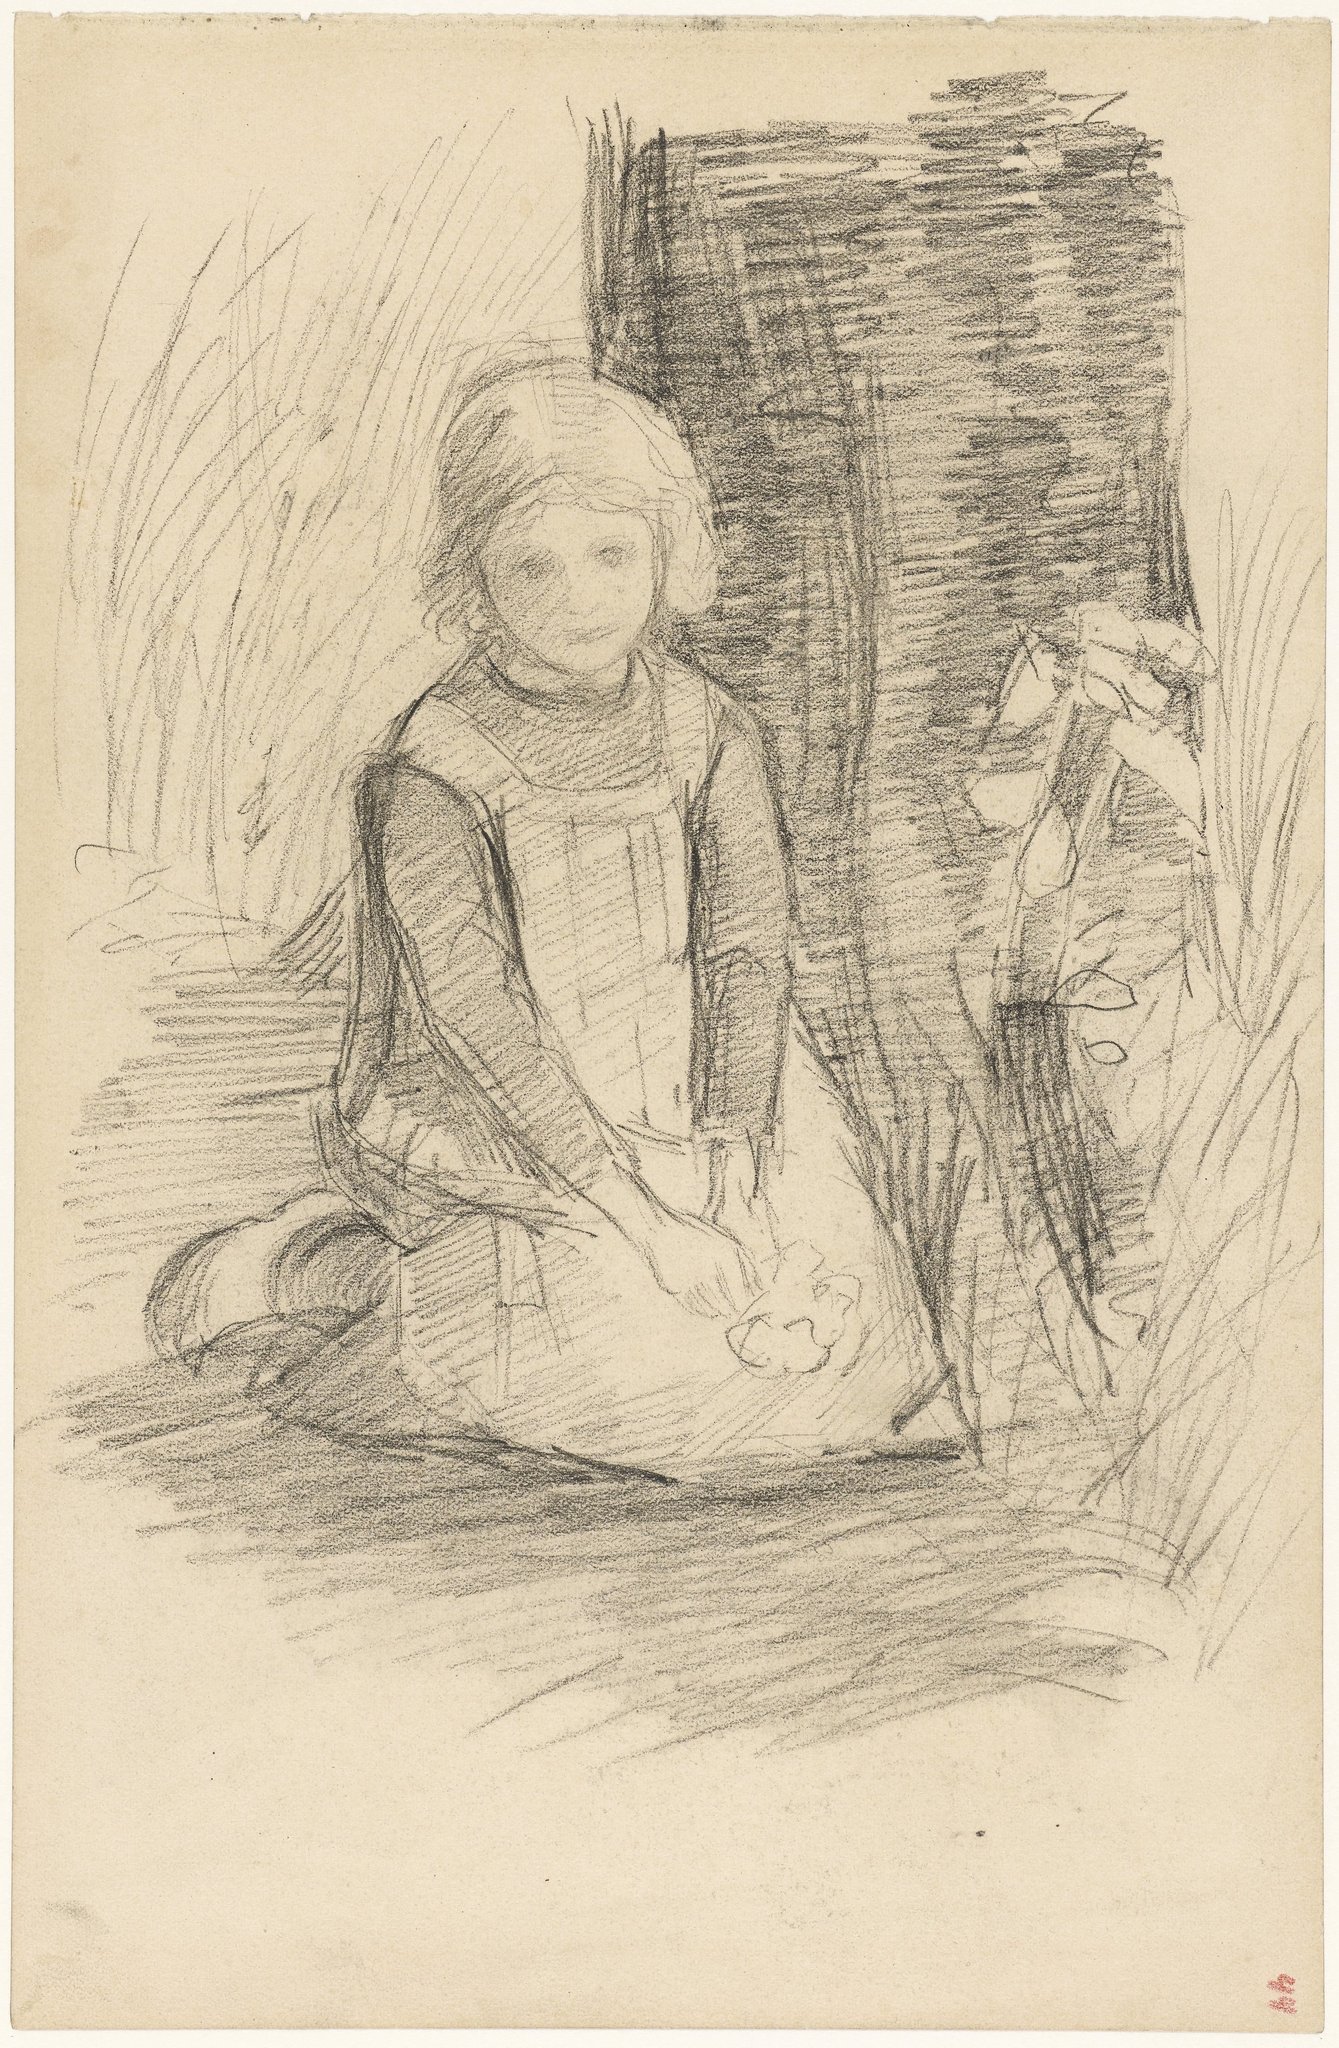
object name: drawing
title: Geknield meisje bij een boom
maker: jozef israëls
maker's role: draughtsman, painter, print maker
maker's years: 1824-1911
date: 1834-1911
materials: chalk, paper